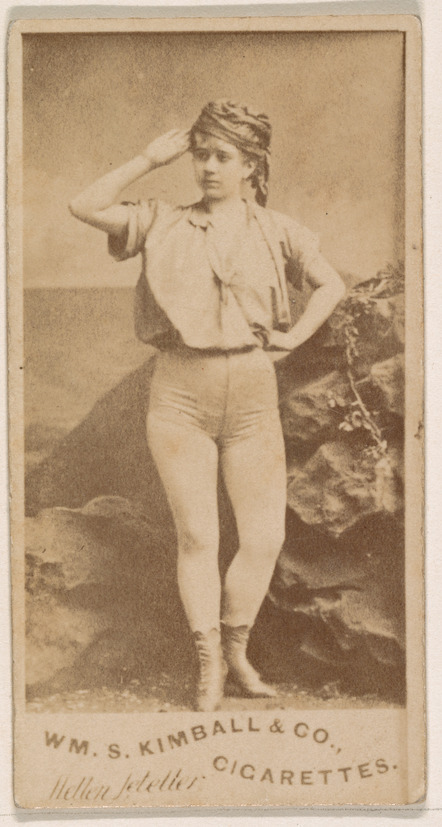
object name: photograph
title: Saluting actress, from the Actresses series (N203) issued by Wm. S. Kimball & Co.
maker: william s. kimball & company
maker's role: publisher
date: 1889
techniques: color lithograph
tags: portraits,women,actresses